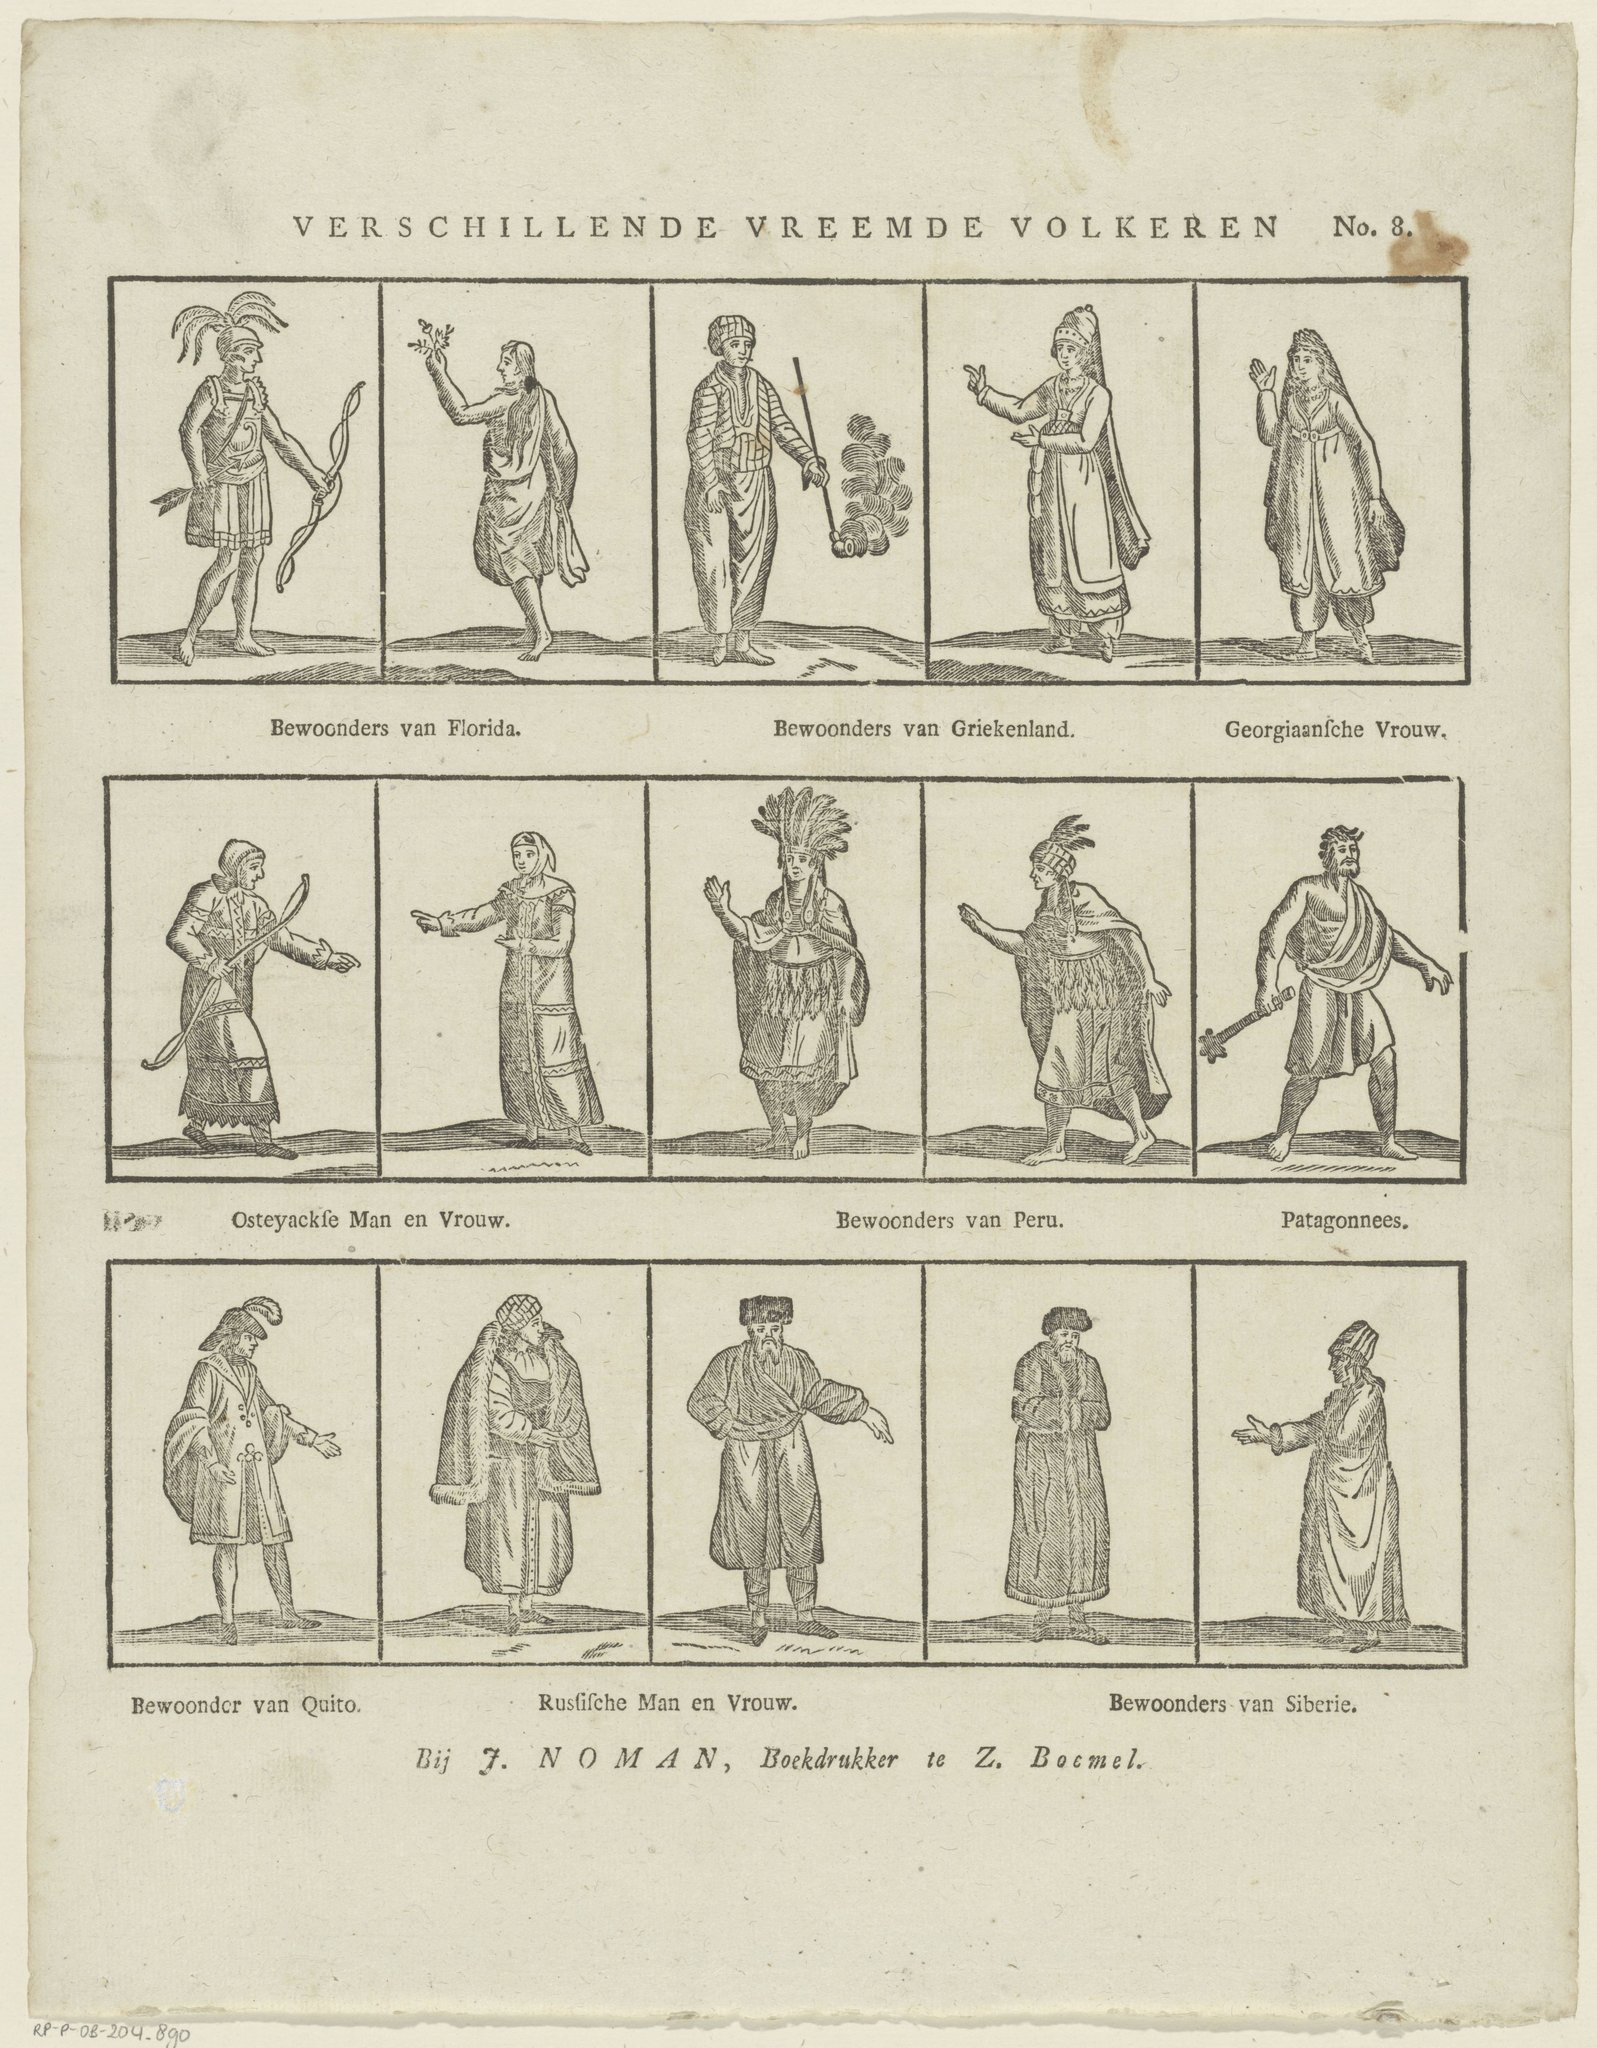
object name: print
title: Verschillende vreemde volkeren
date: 1806-1830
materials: paper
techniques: letterpress printing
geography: zaltbommel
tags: europeans, indigenous peoples of south america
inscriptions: collector's mark: Lugt 2760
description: Blad met 15 voorstellingen van verschillende vreemde volkeren. Onder elke afbeelding (soms per twee) een onderschrift. Genummerd rechtsboven: No. 8.